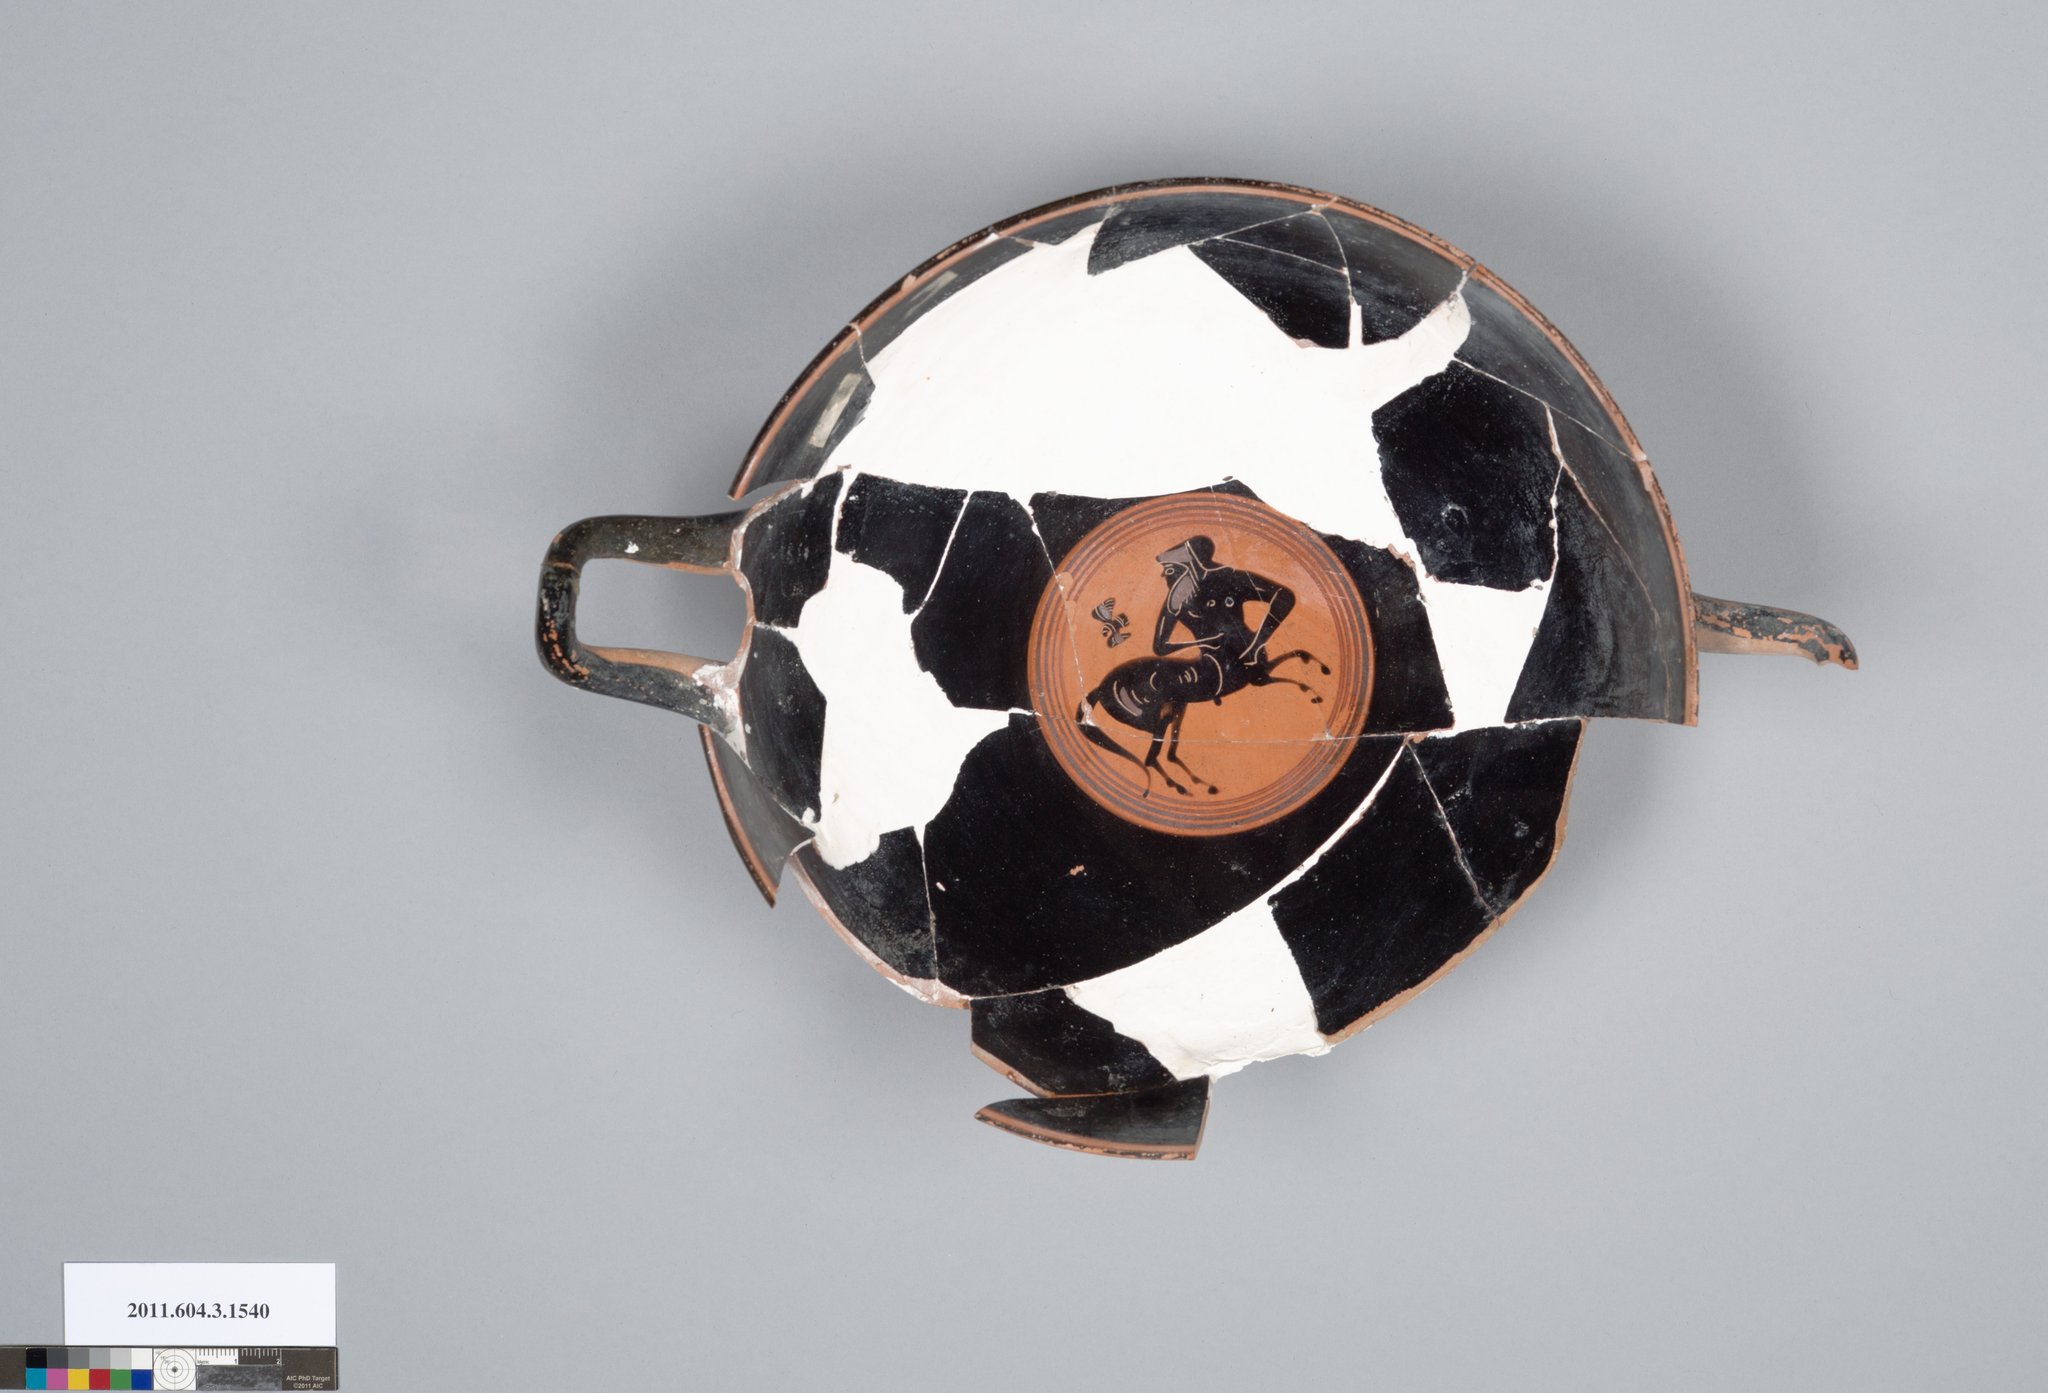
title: Terracotta fragment of a kylix: eye-cup (drinking cup)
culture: greek, attic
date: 520-500 BCE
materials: terracotta